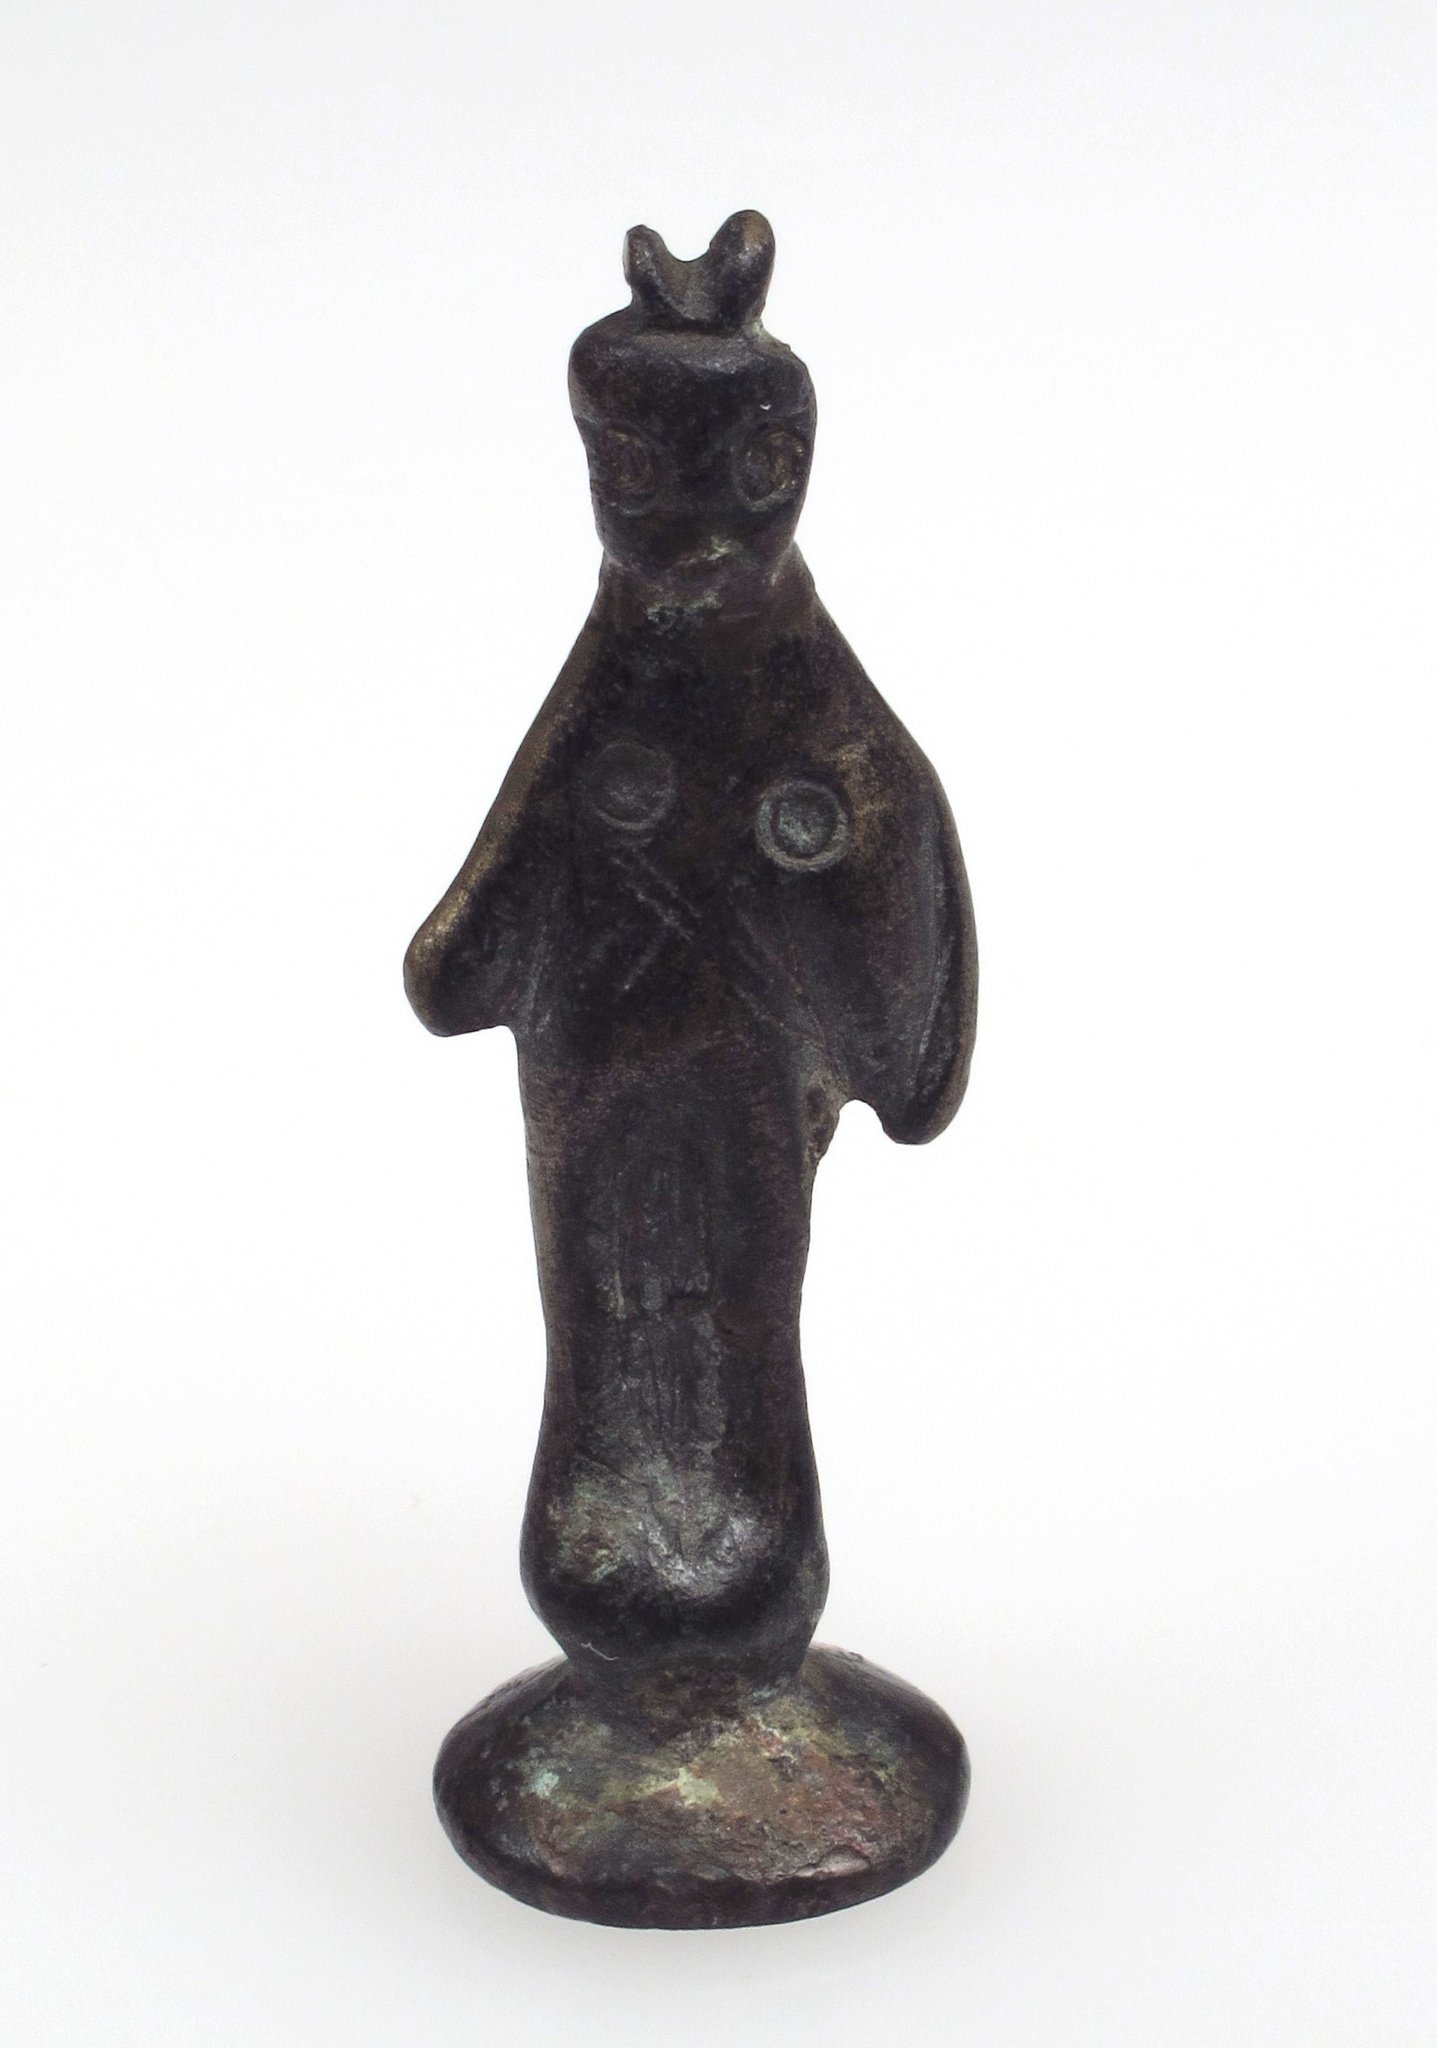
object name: figure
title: Votive Figure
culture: hallstatt period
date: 700-601 BCE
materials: copper alloy